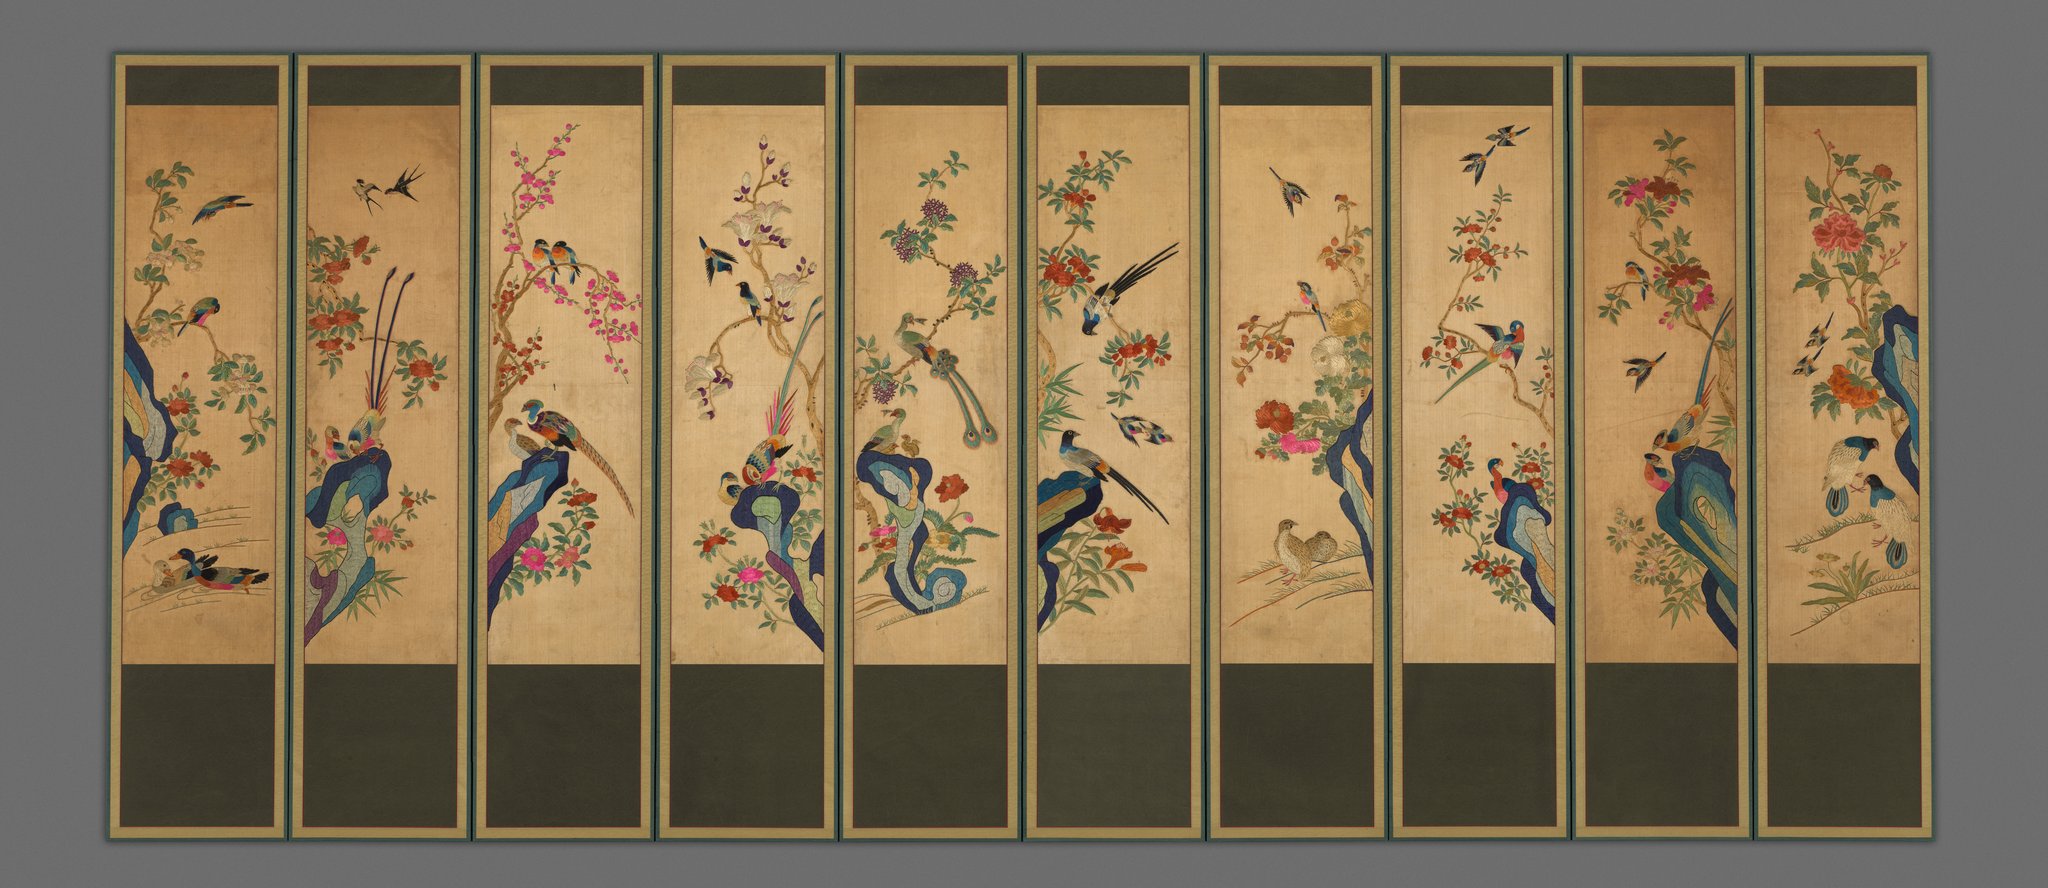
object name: screen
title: Birds and Flowers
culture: korean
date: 1867-1900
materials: panel, silk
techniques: embroidery